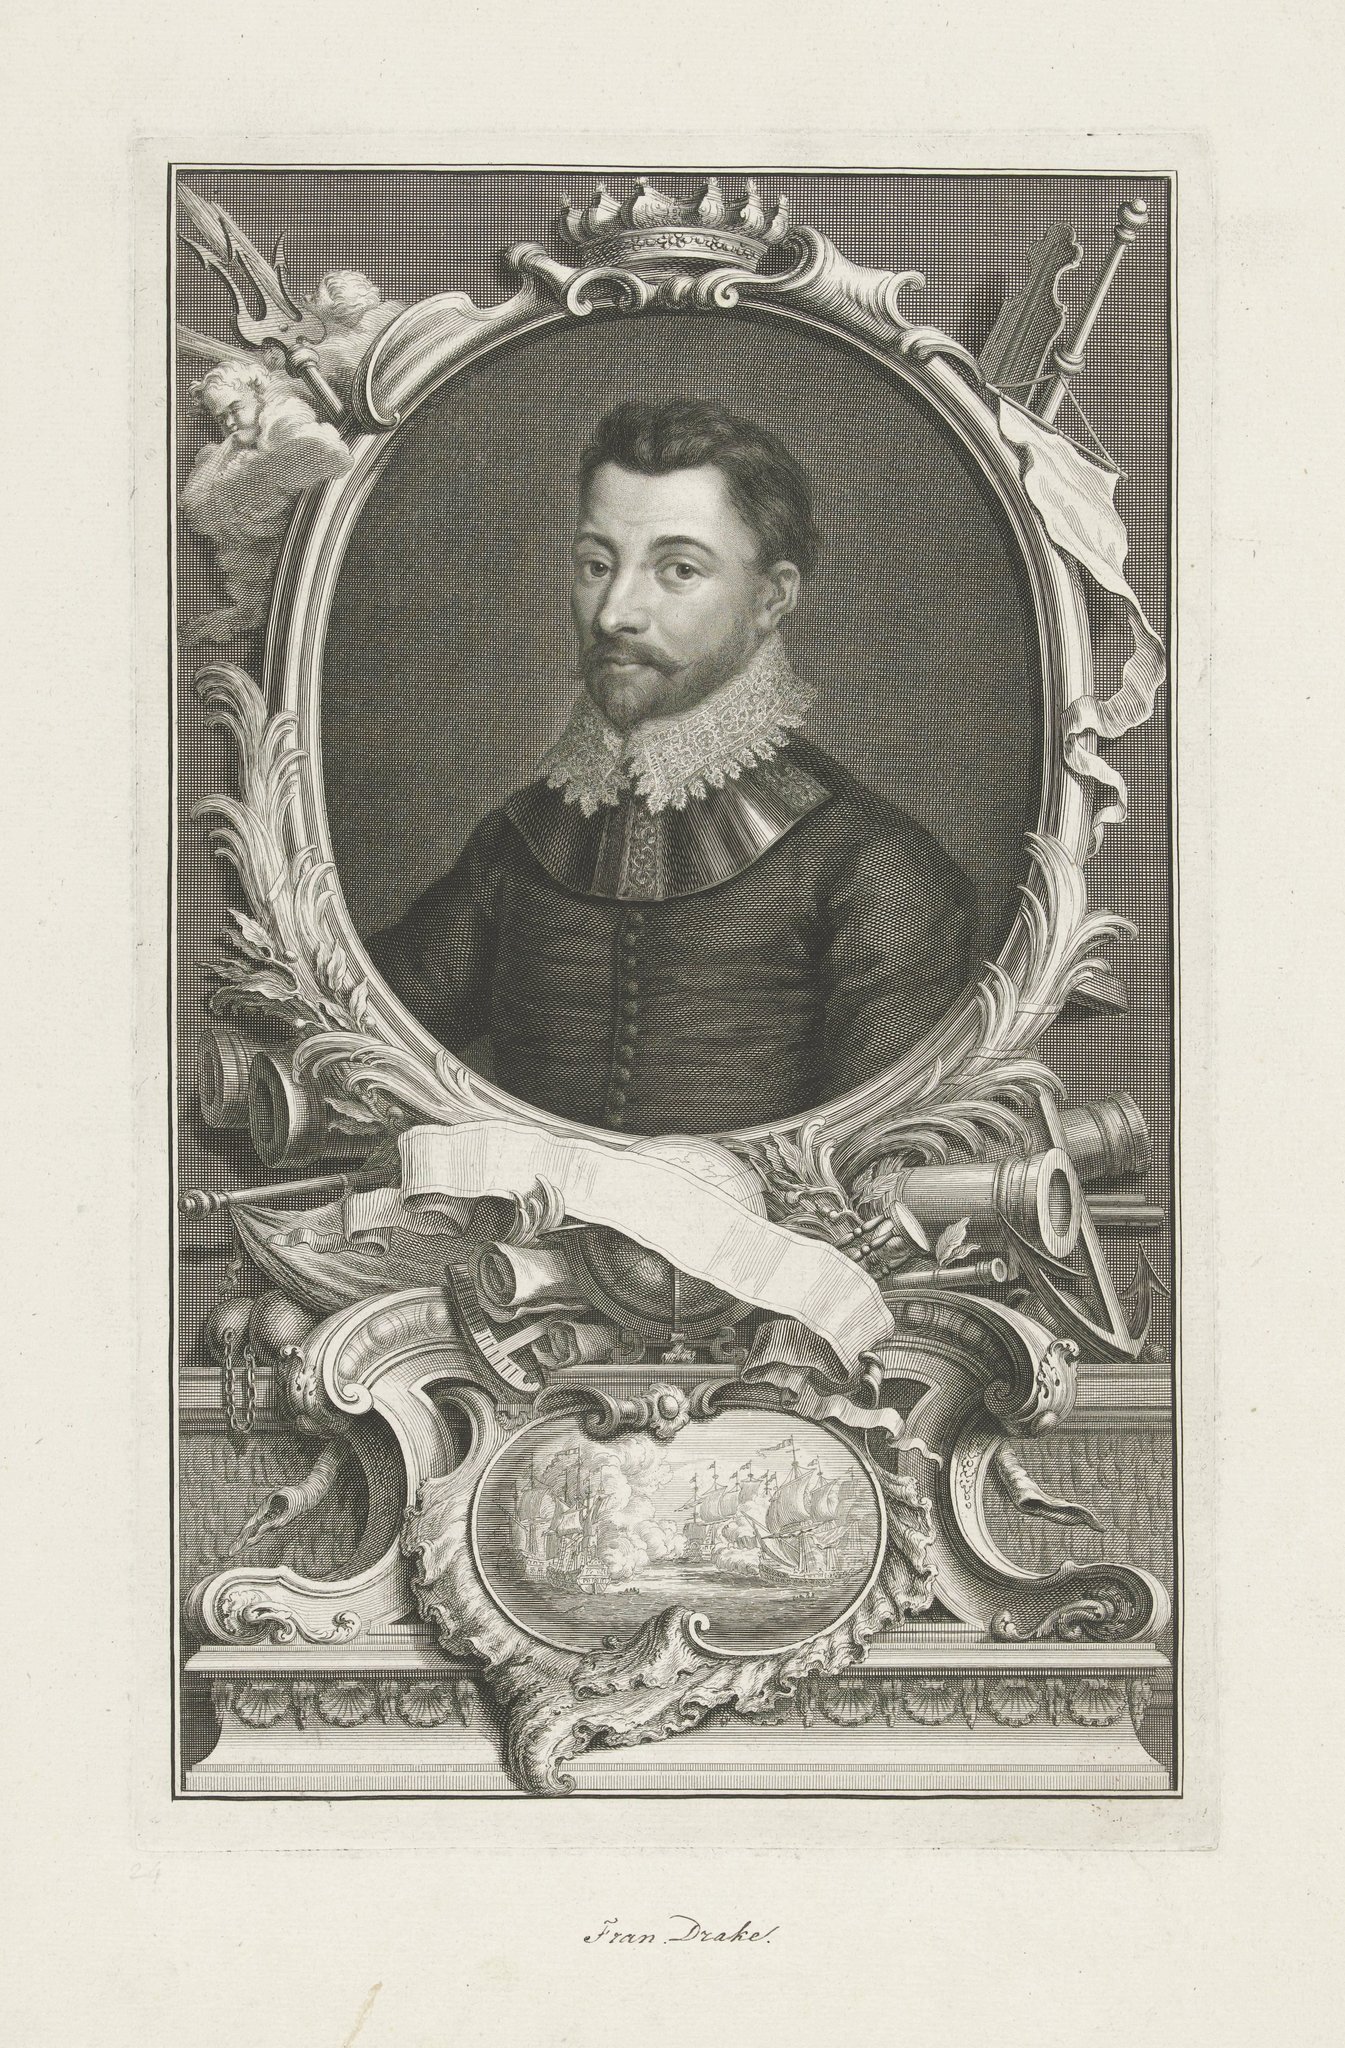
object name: print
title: Portret van Francis Drake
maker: jacob houbraken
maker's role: draughtsman, print maker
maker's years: 1698-1780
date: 1741-1743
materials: paper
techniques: engraving, etching, pen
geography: amsterdam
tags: admiraal, francis drake (1540-1596)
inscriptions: name: ‘Fran. Drake’, collector's mark: Lugt 240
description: Prent ook gebruikt in: Thomas Birch. The heads of illustrious persons of Great Britain : engraved by Houbraken, and Vertue, with their lives and characters. London: John en Paul Knapton, 1743-1751.